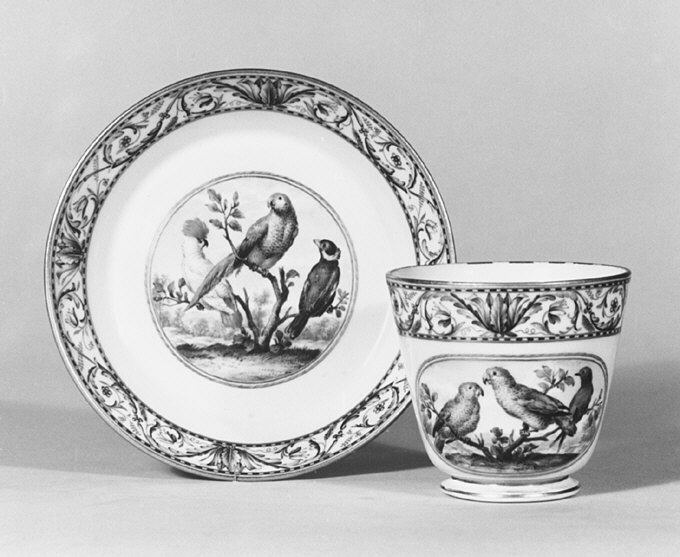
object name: saucer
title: Saucer (part of a service)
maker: meissen manufactory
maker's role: manufactory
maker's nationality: german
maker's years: 1710-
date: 1780-1785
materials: hard paste porcelain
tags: parrots,flowers